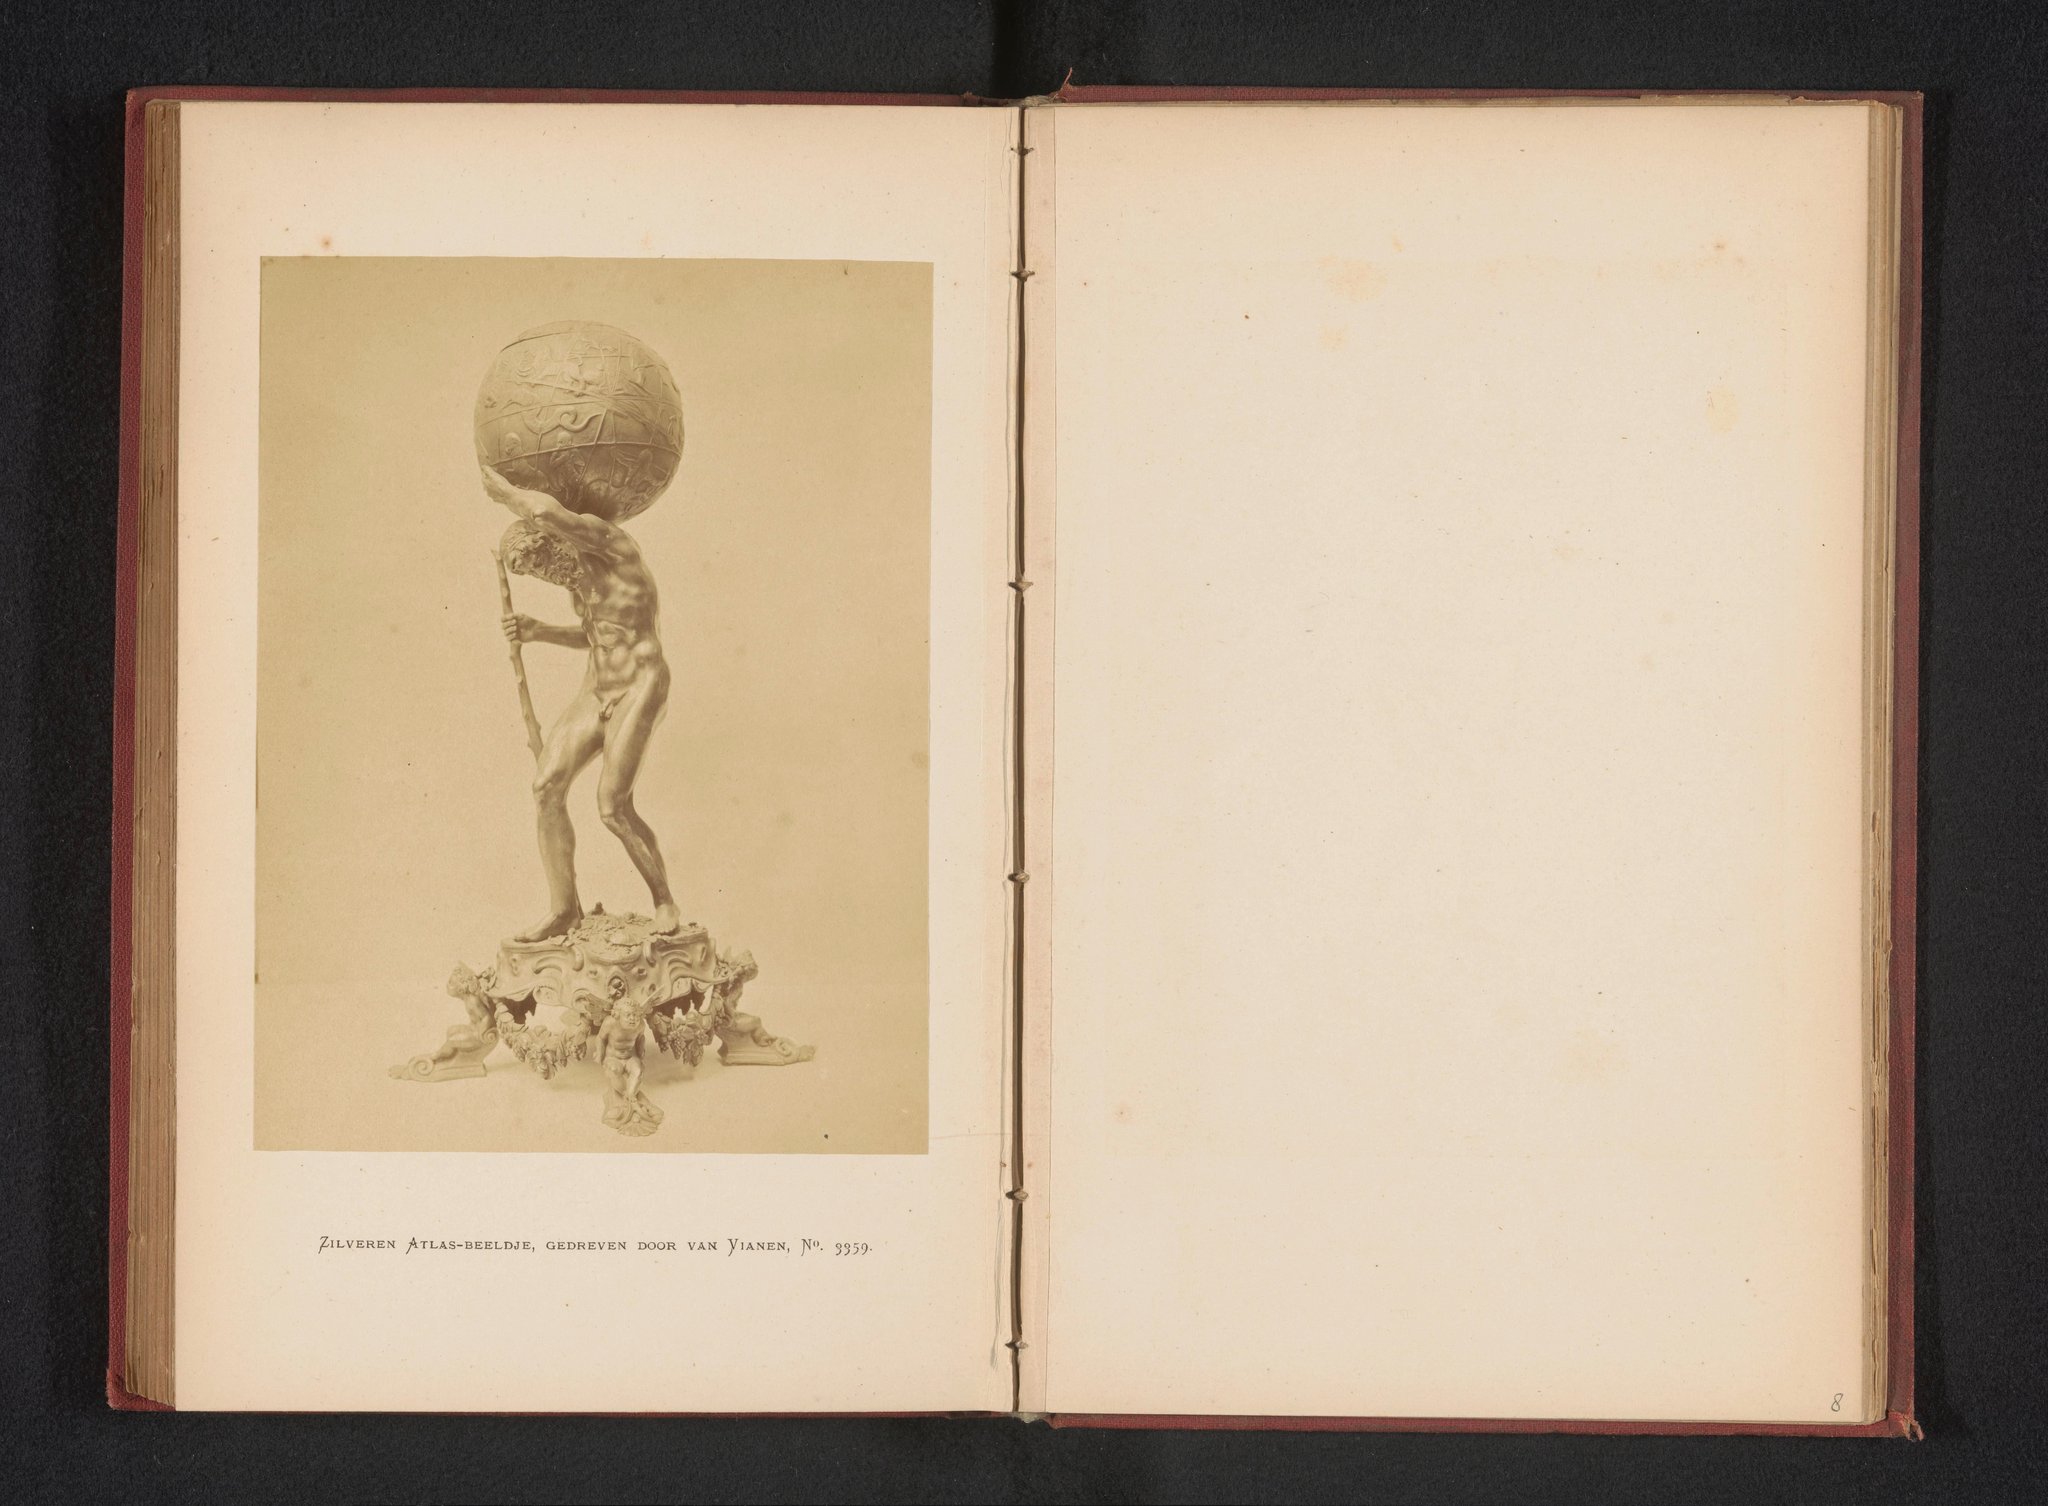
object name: photograph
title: Zilveren Atlas-beeldje, gedreven door van Vianen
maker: pieter oosterhuis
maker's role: draughtsman, print maker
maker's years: 1816-1885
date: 1876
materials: photographic support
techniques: albumen print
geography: amsterdam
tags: atlas supporting the heavens on his shoulders, piece of sculpture, reproduction of a piece of sculpture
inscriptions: number: ‘No. 3359.’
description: Foto op vierde ongenummerde pagina na pagina 204.